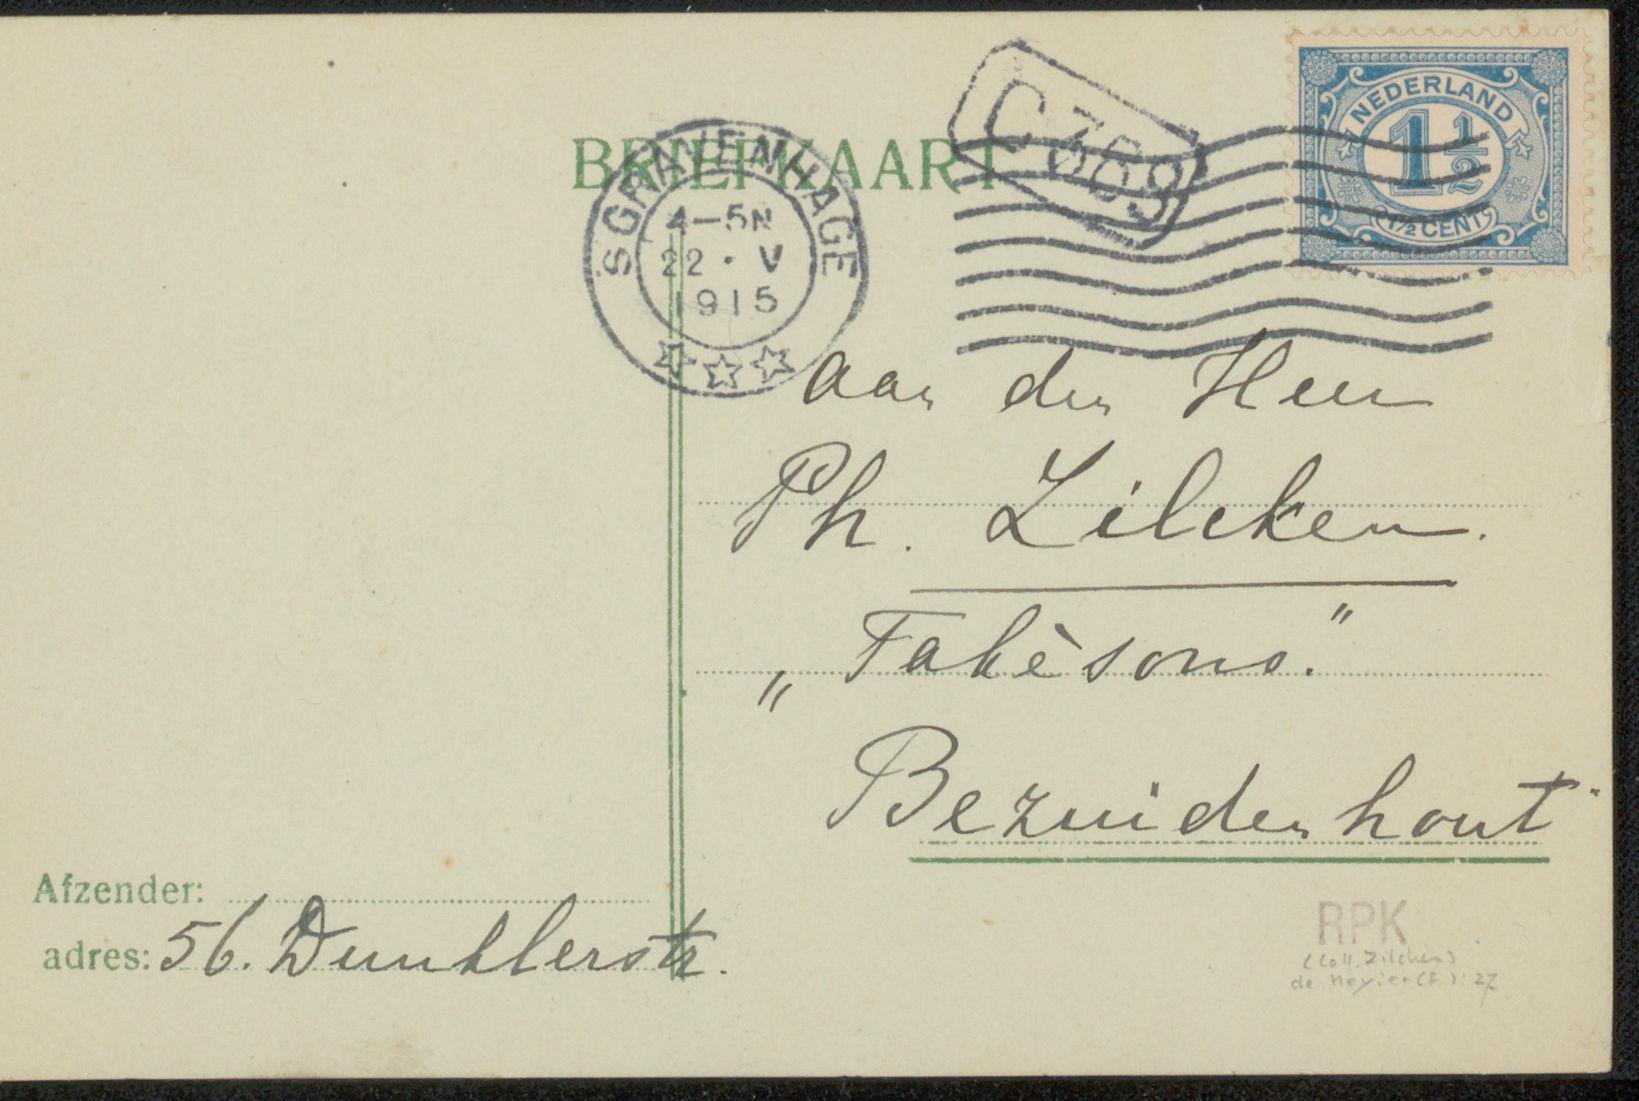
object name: postcard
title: Briefkaart aan Philip Zilcken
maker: fenna de meyier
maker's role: onderwijzer, schrijver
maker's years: 1874-1943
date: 1915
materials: cardboard, ink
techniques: pen, writing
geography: the hague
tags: the hague, painter, draughtsman, philip zilcken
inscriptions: collector's mark: ‘RPK’